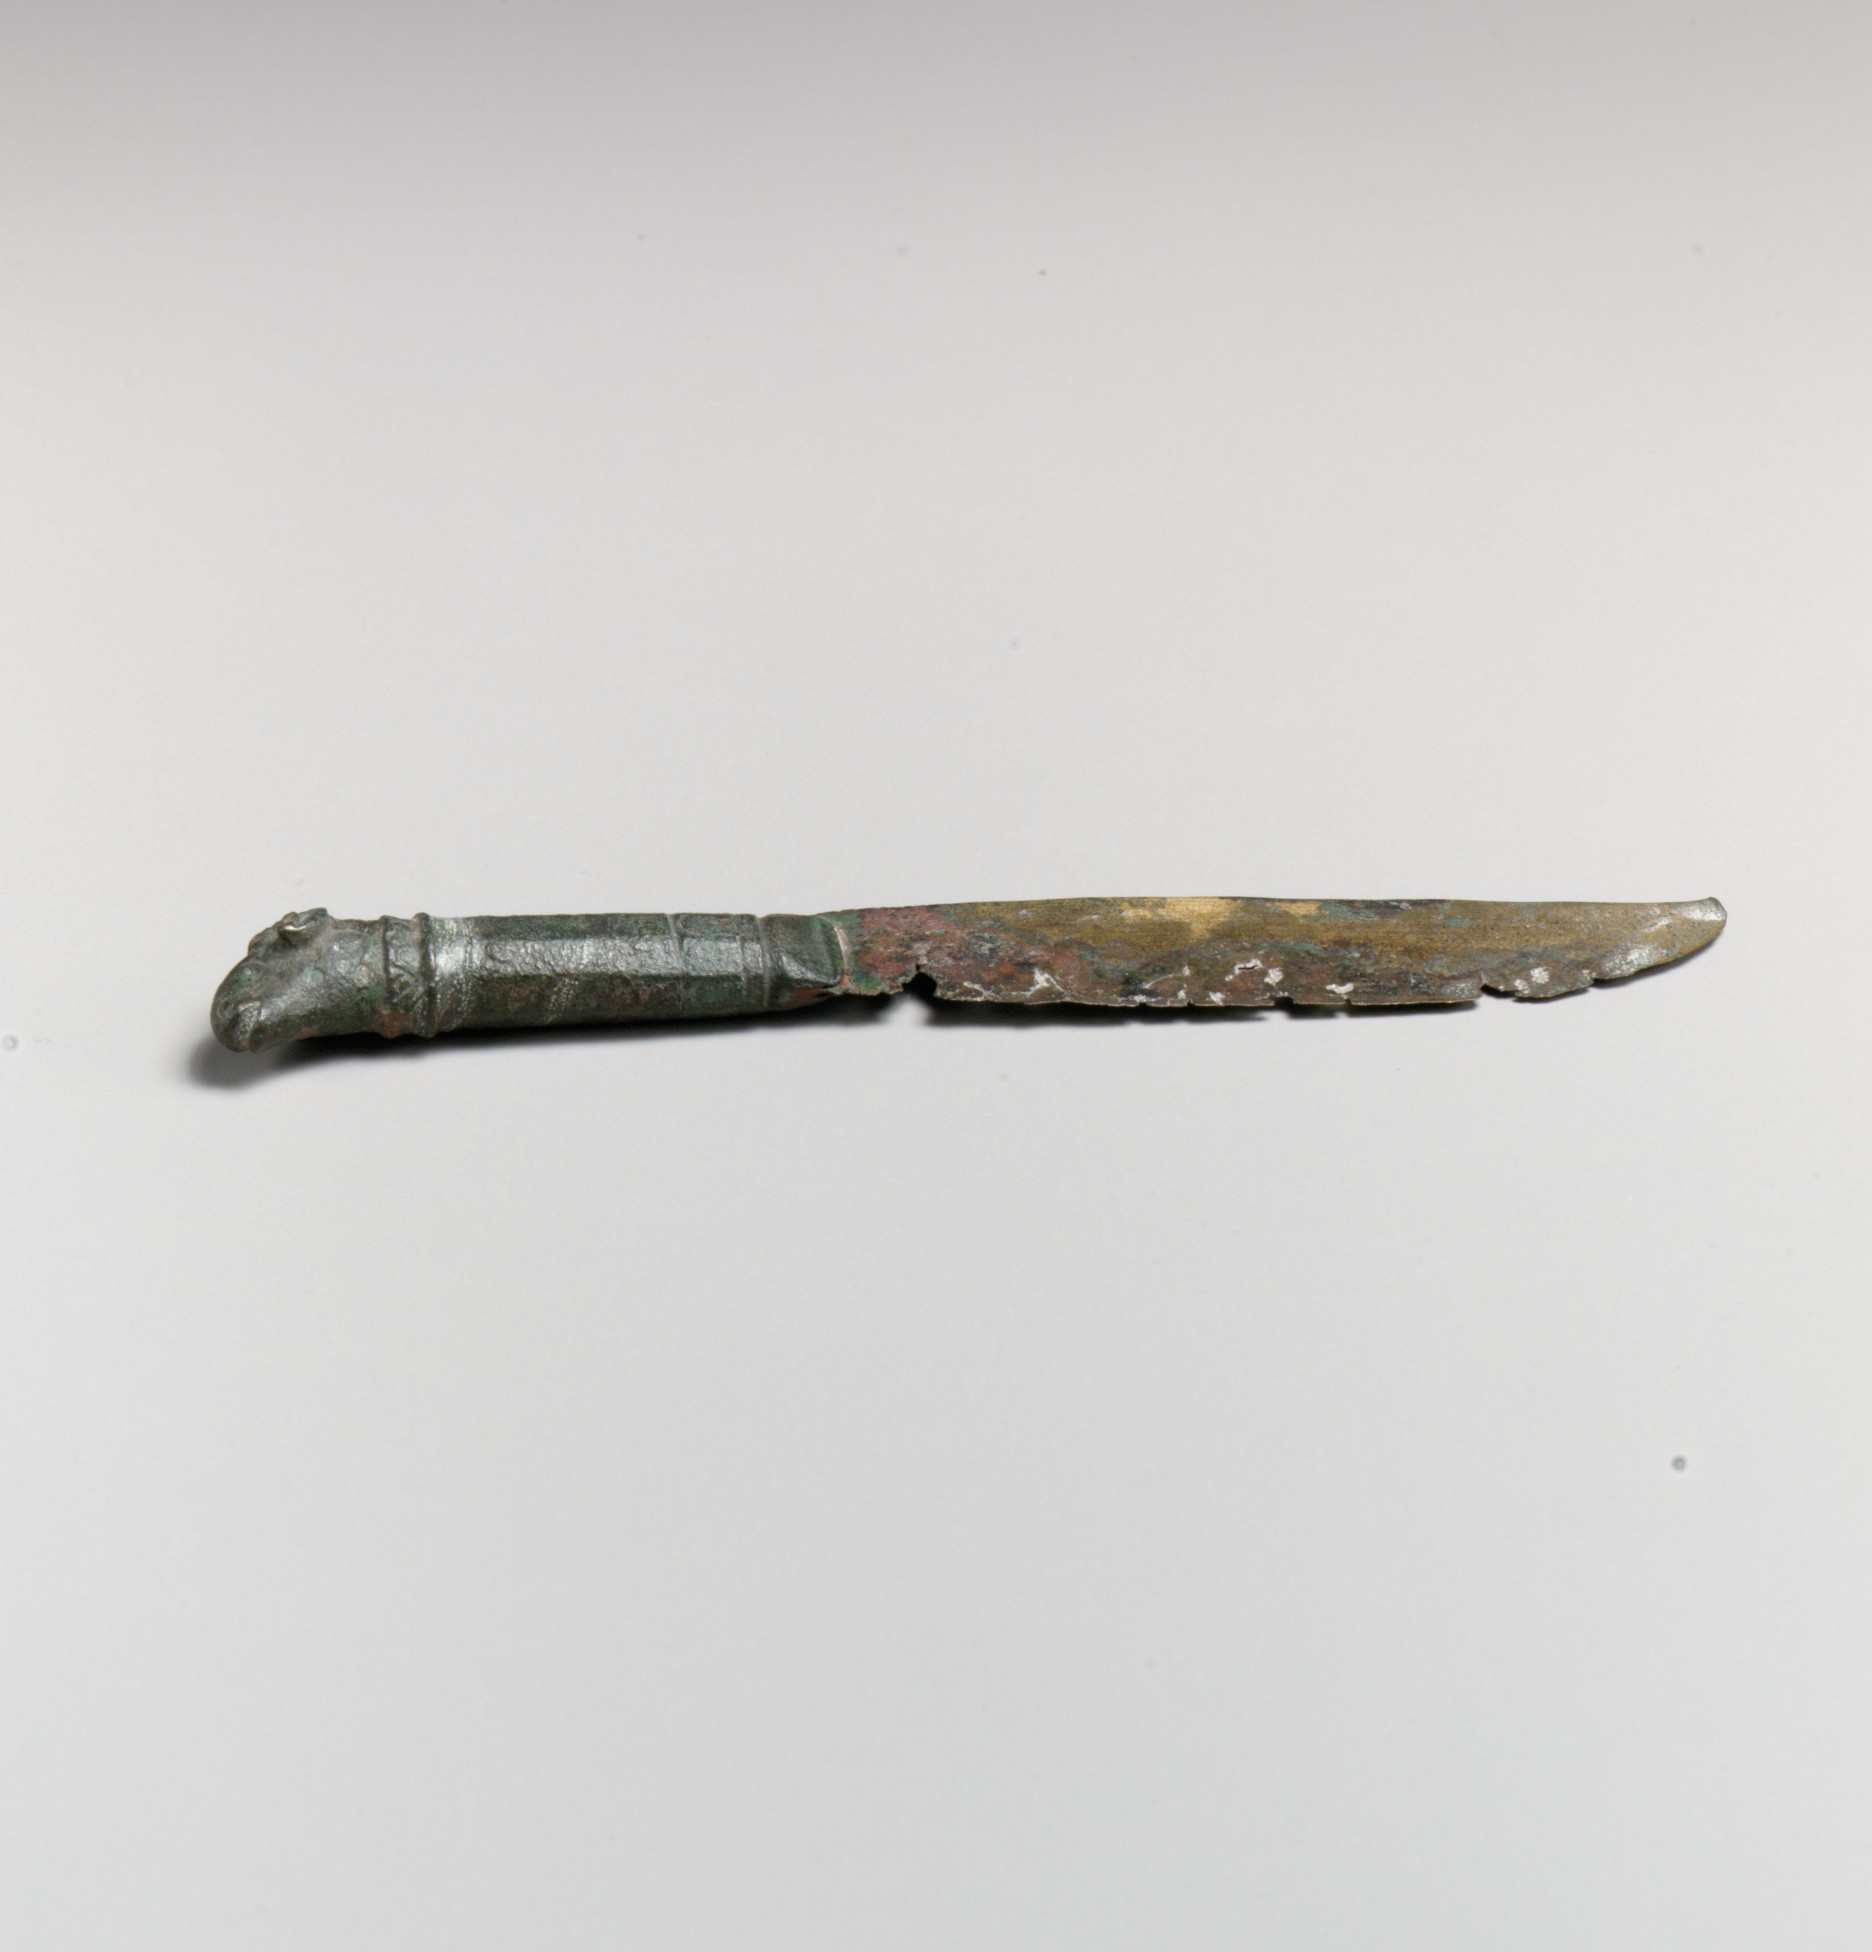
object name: knife with ram's head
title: Bronze knife with ram's-head handle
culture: roman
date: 1-100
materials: bronze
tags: knives,rams